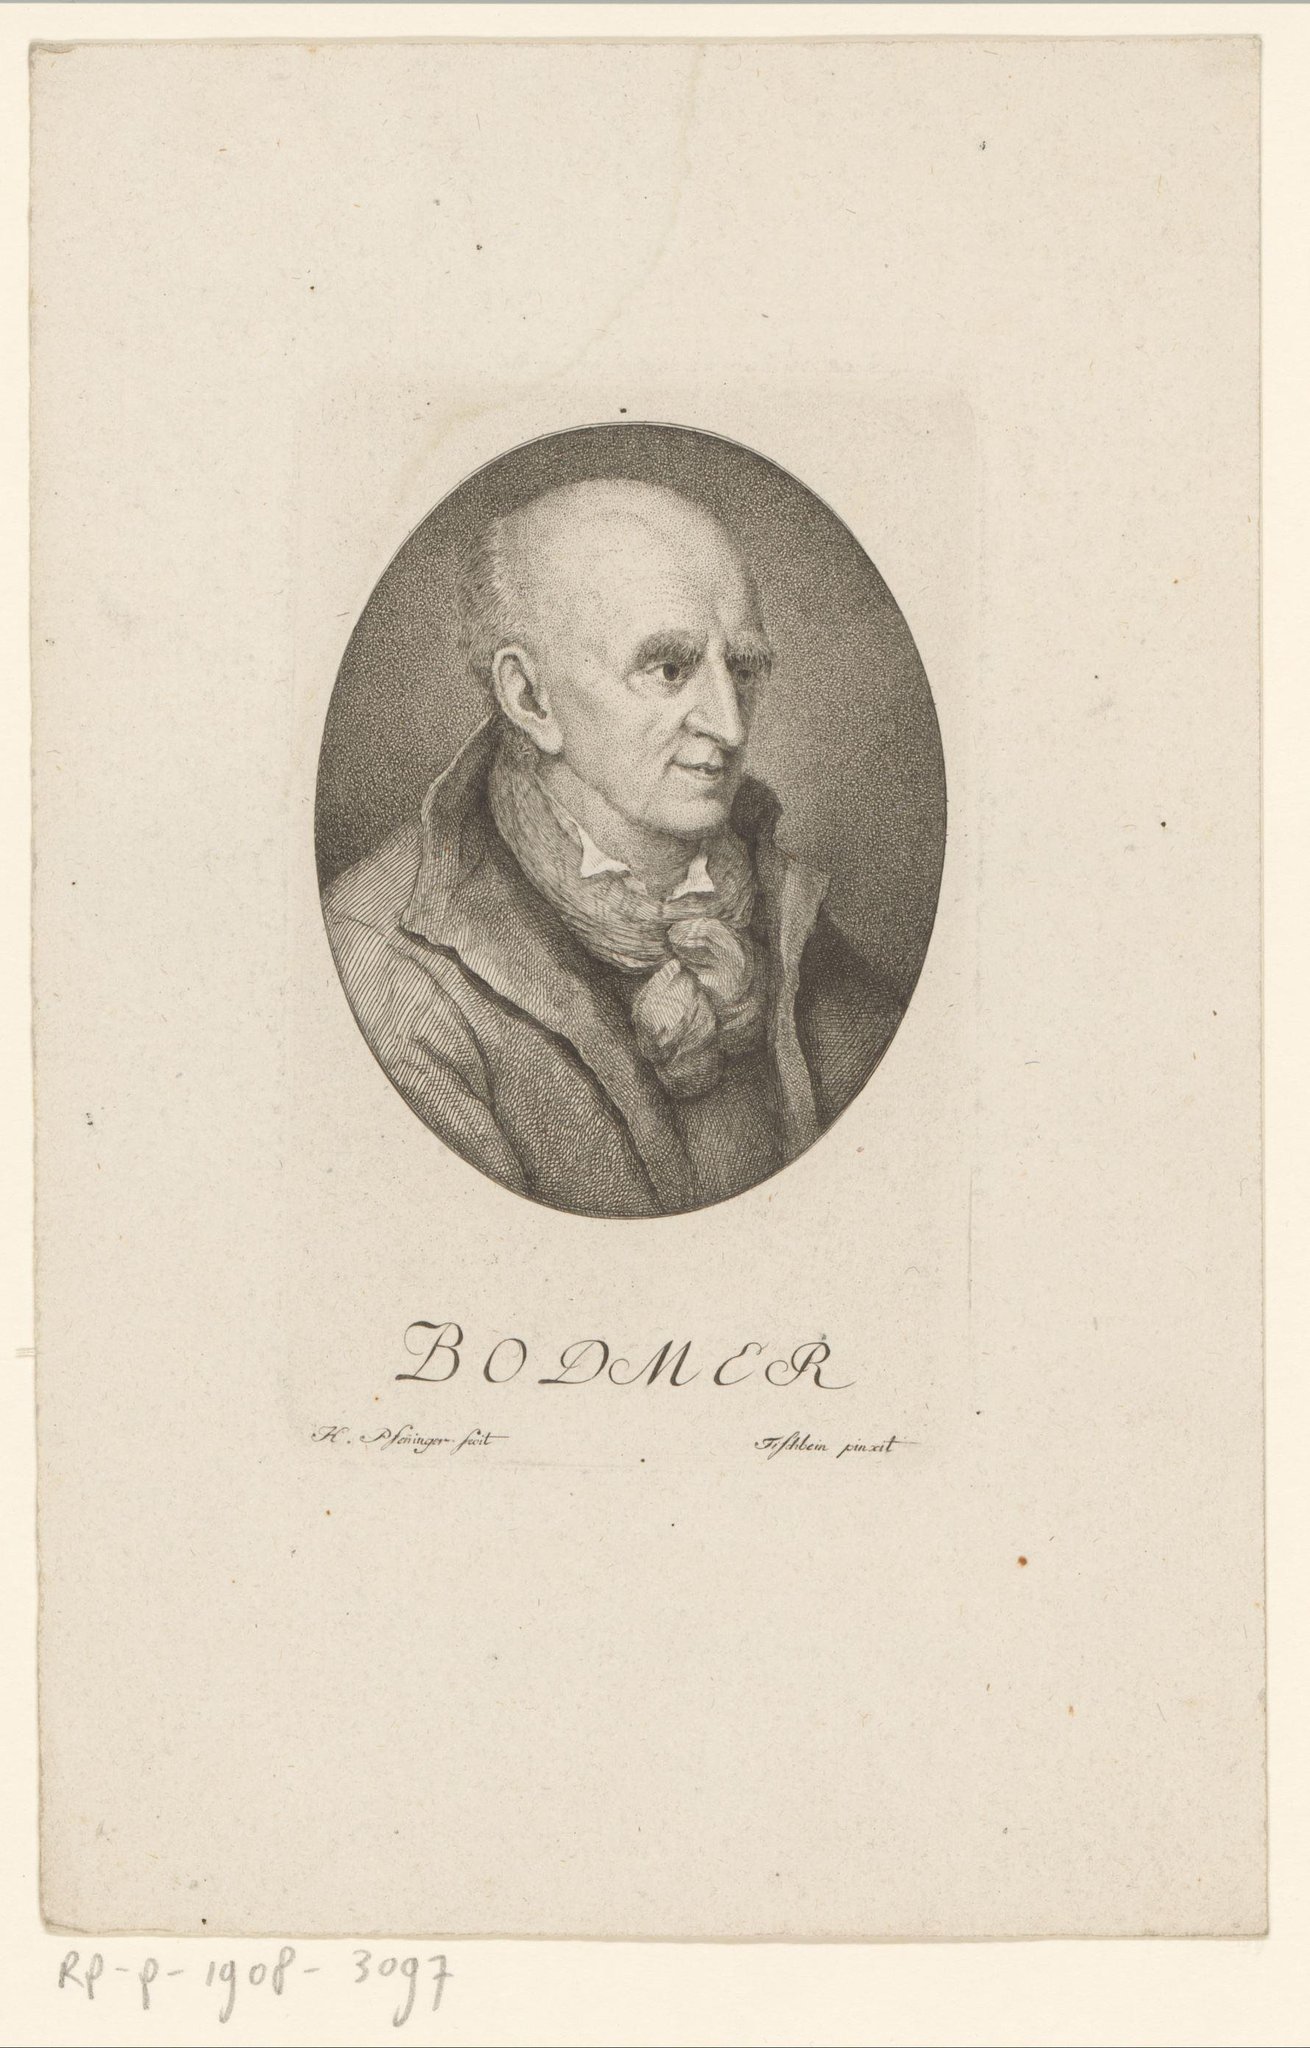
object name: print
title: Portret van Johann Jacob Bodmer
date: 1759-1815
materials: paper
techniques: etching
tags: historical persons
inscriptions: collector's mark: Lugt 2228